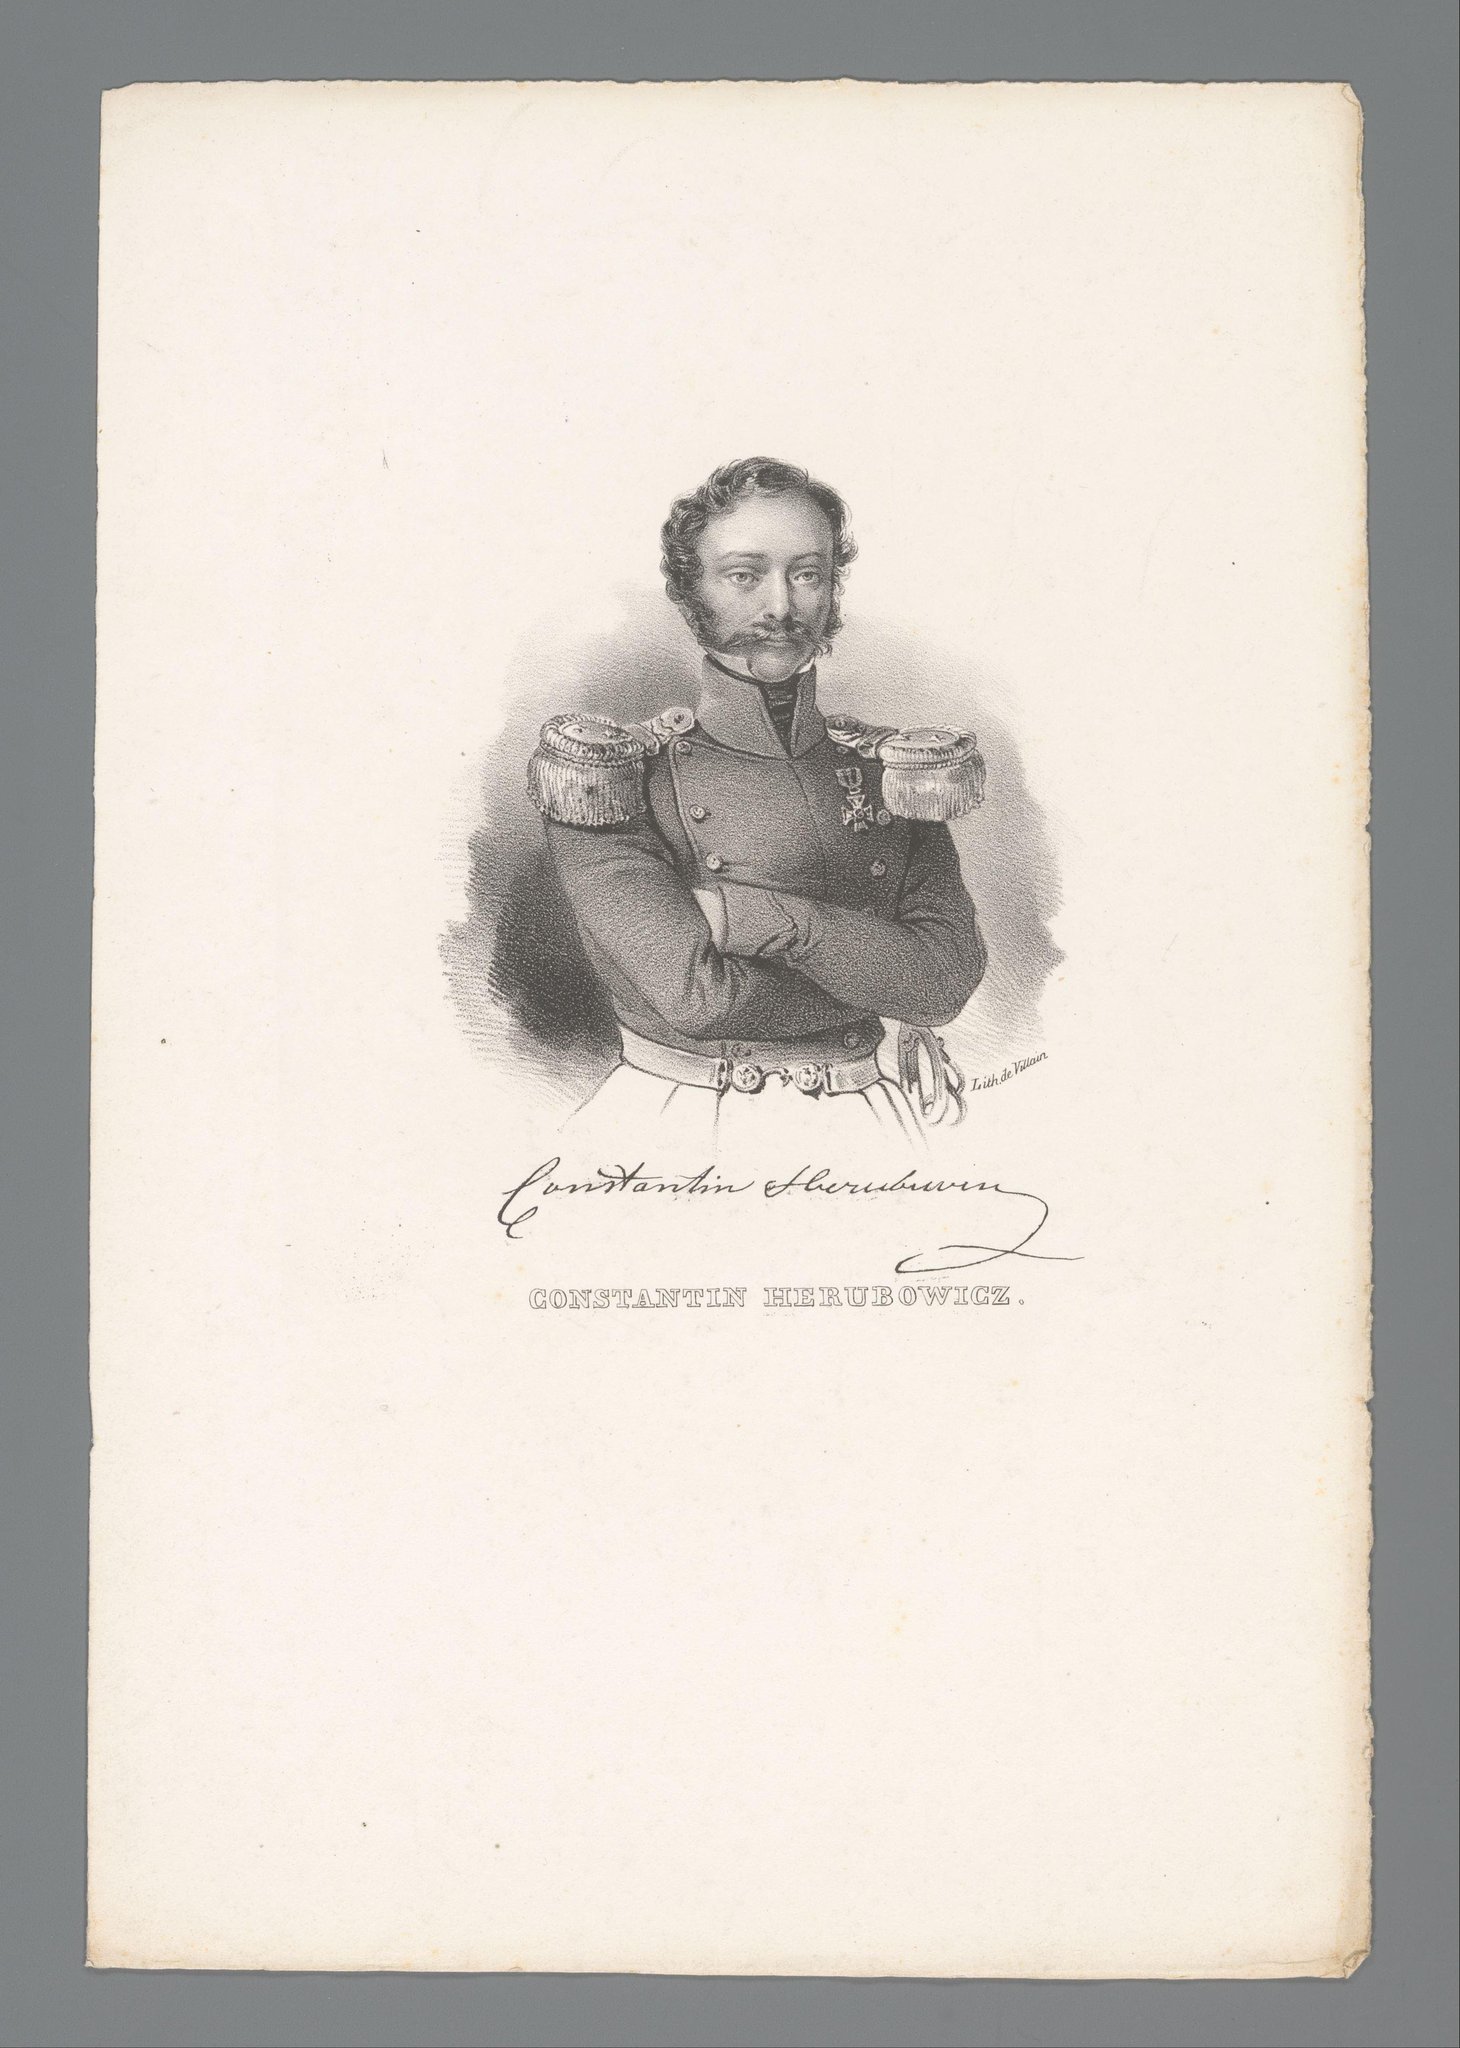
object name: print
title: Constantin Herubowicz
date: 1832-1839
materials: paper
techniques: lithograph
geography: paris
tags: historical persons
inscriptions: collector's mark: Lugt 2228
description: Prent uit: Straszewicz., Joseph. Les polonais et les polonaises de la révolution du 29 novembre 1830, ou Portraits des personnes qui ont figuré dans la dernière guerre de l'indépendance polonaise, avec les fac-simile de leur signature, lithographiés sur dessins originaux, par les artistes les plus distingués: MM. Grévedon, Maurin, Vigneron, Belliard, Devéria, Bazin, Desmadryl, Lecler, Desmaisons, Rutowski, officier polonais, etc,. etc., accompagnés d'une biographie pour chaque portrait. Parijs: Catherine-Anaïs Pinard, 1832. Of uit: Straszewicz., Joseph. Les polonais et les polonaises de la révolution du 29 novembre 1830. Biographie des personnes qui ont figuré dans la dernière guerre de l'indépendance polonaise, avec les fac-simile de leur signature, ornée de 30 portraits lithographiés sur dessins originaux, par les artistes les plus distingués: MM. Grévedon, Maurin, Vigneron, Belliard, Devéria, Bazin, Desmadryl, Lecler, etc., etc.. Parijs: s.n., 1839.